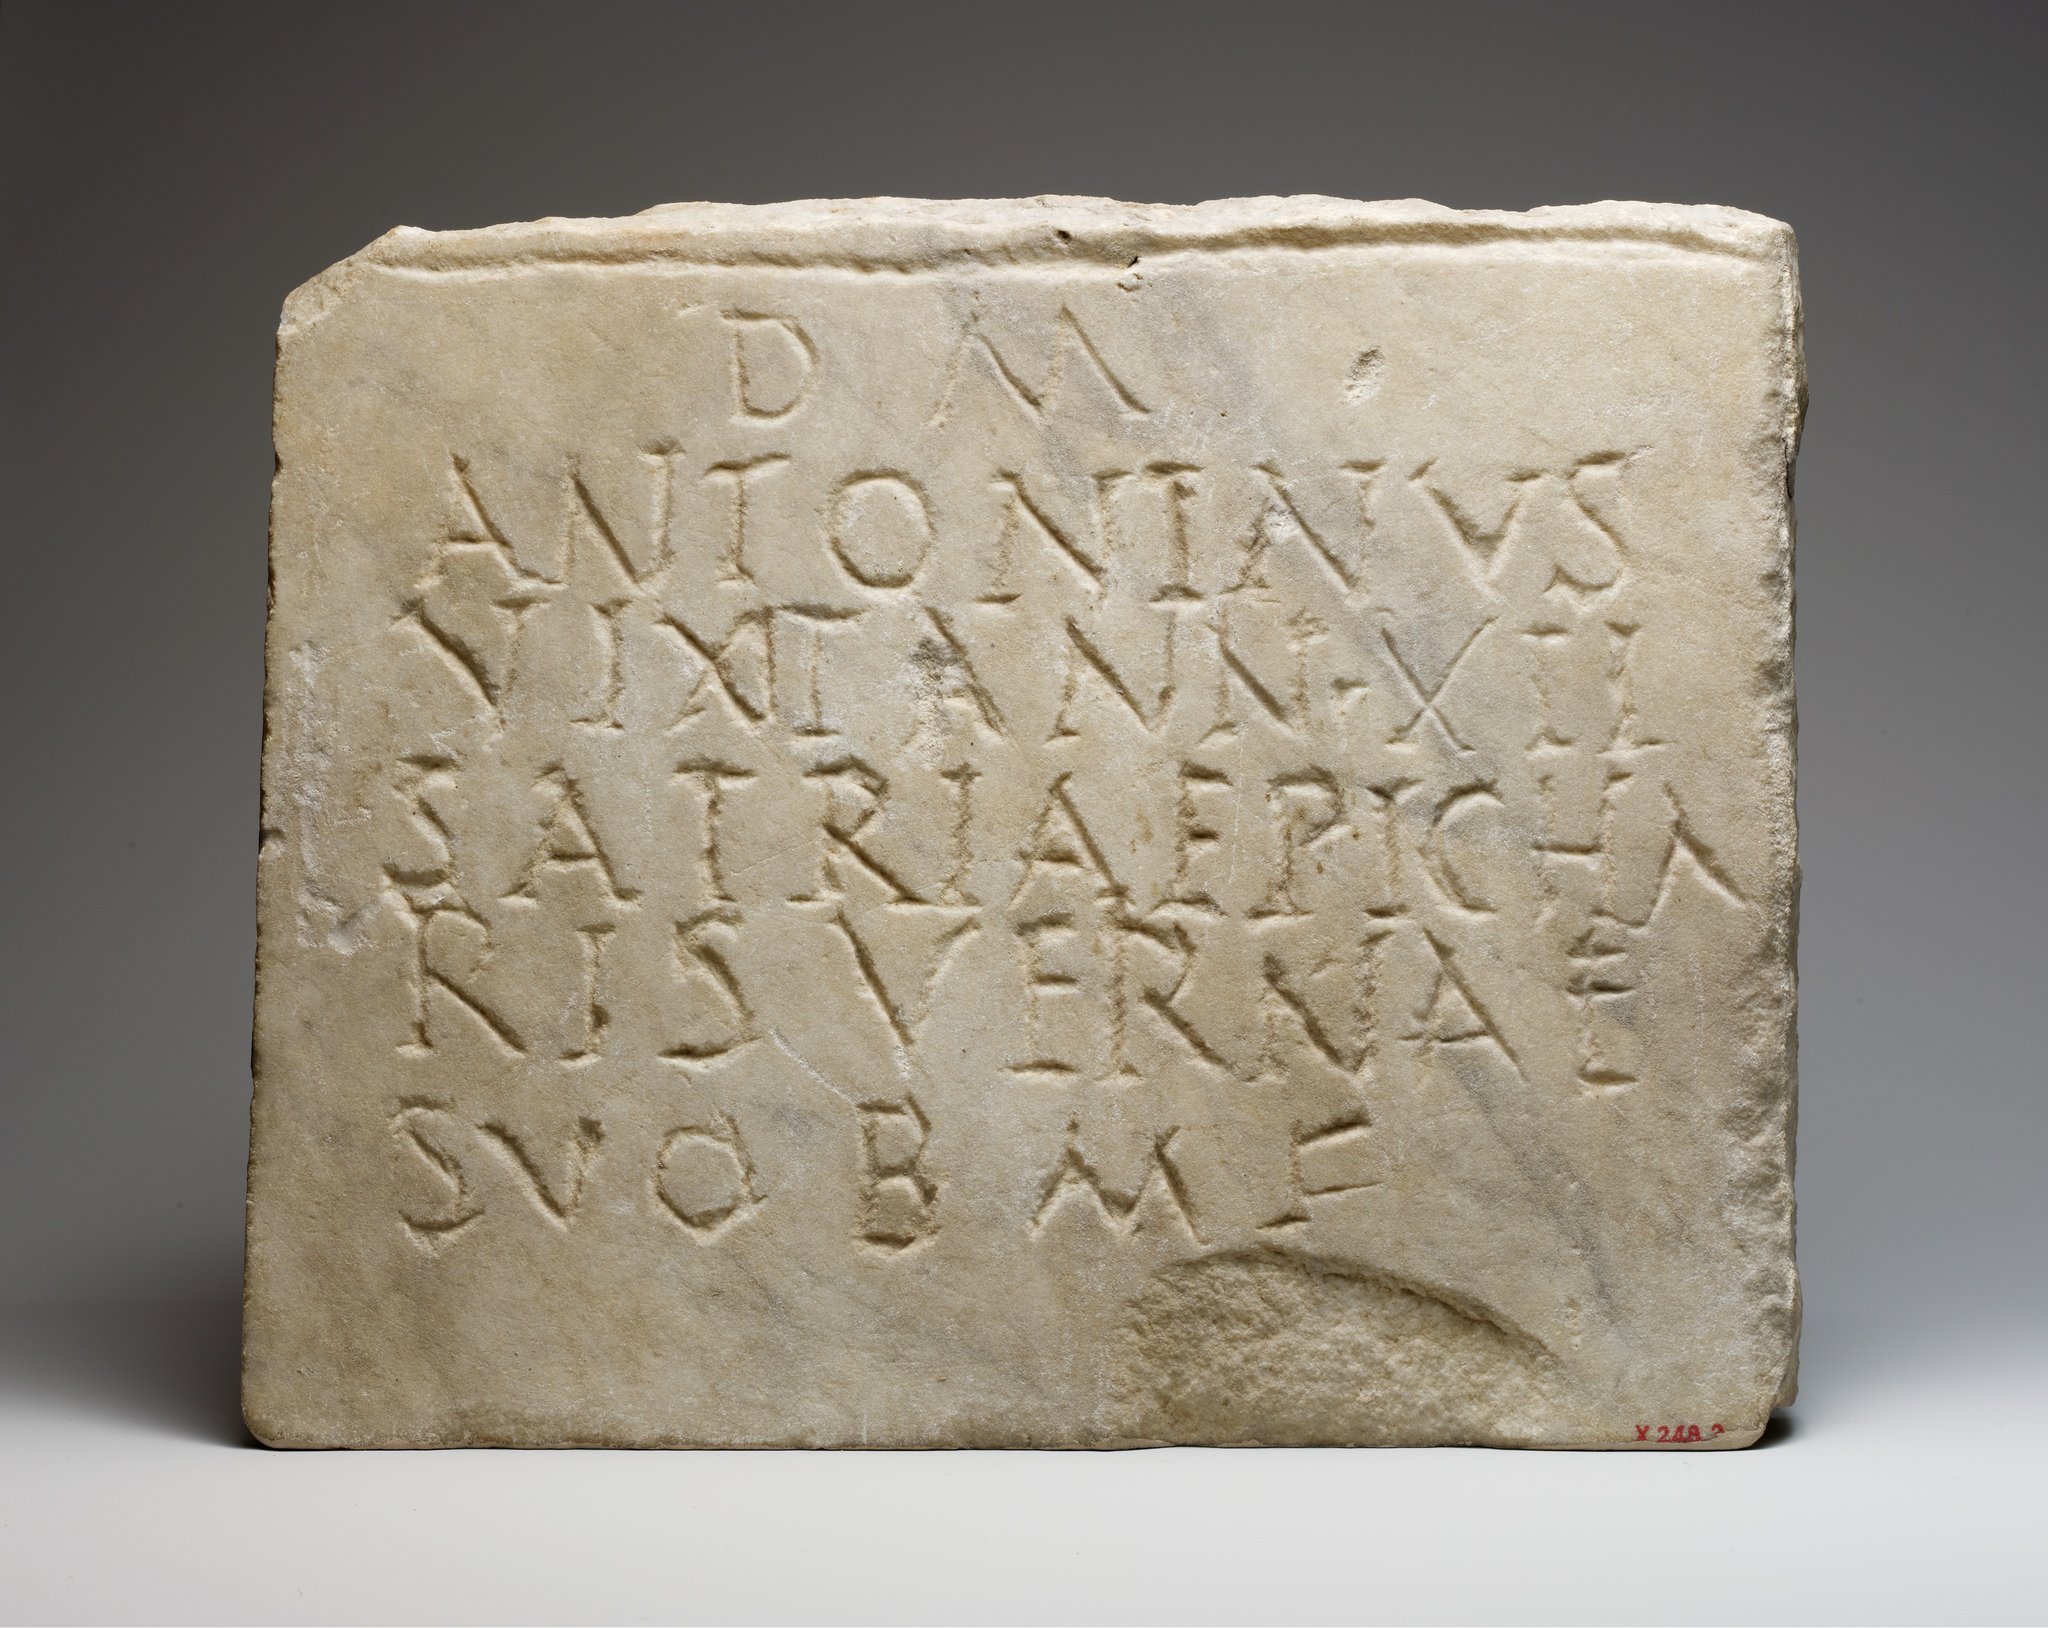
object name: plaque with funerary inscription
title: Marble funerary inscription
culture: roman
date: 201-233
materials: marble